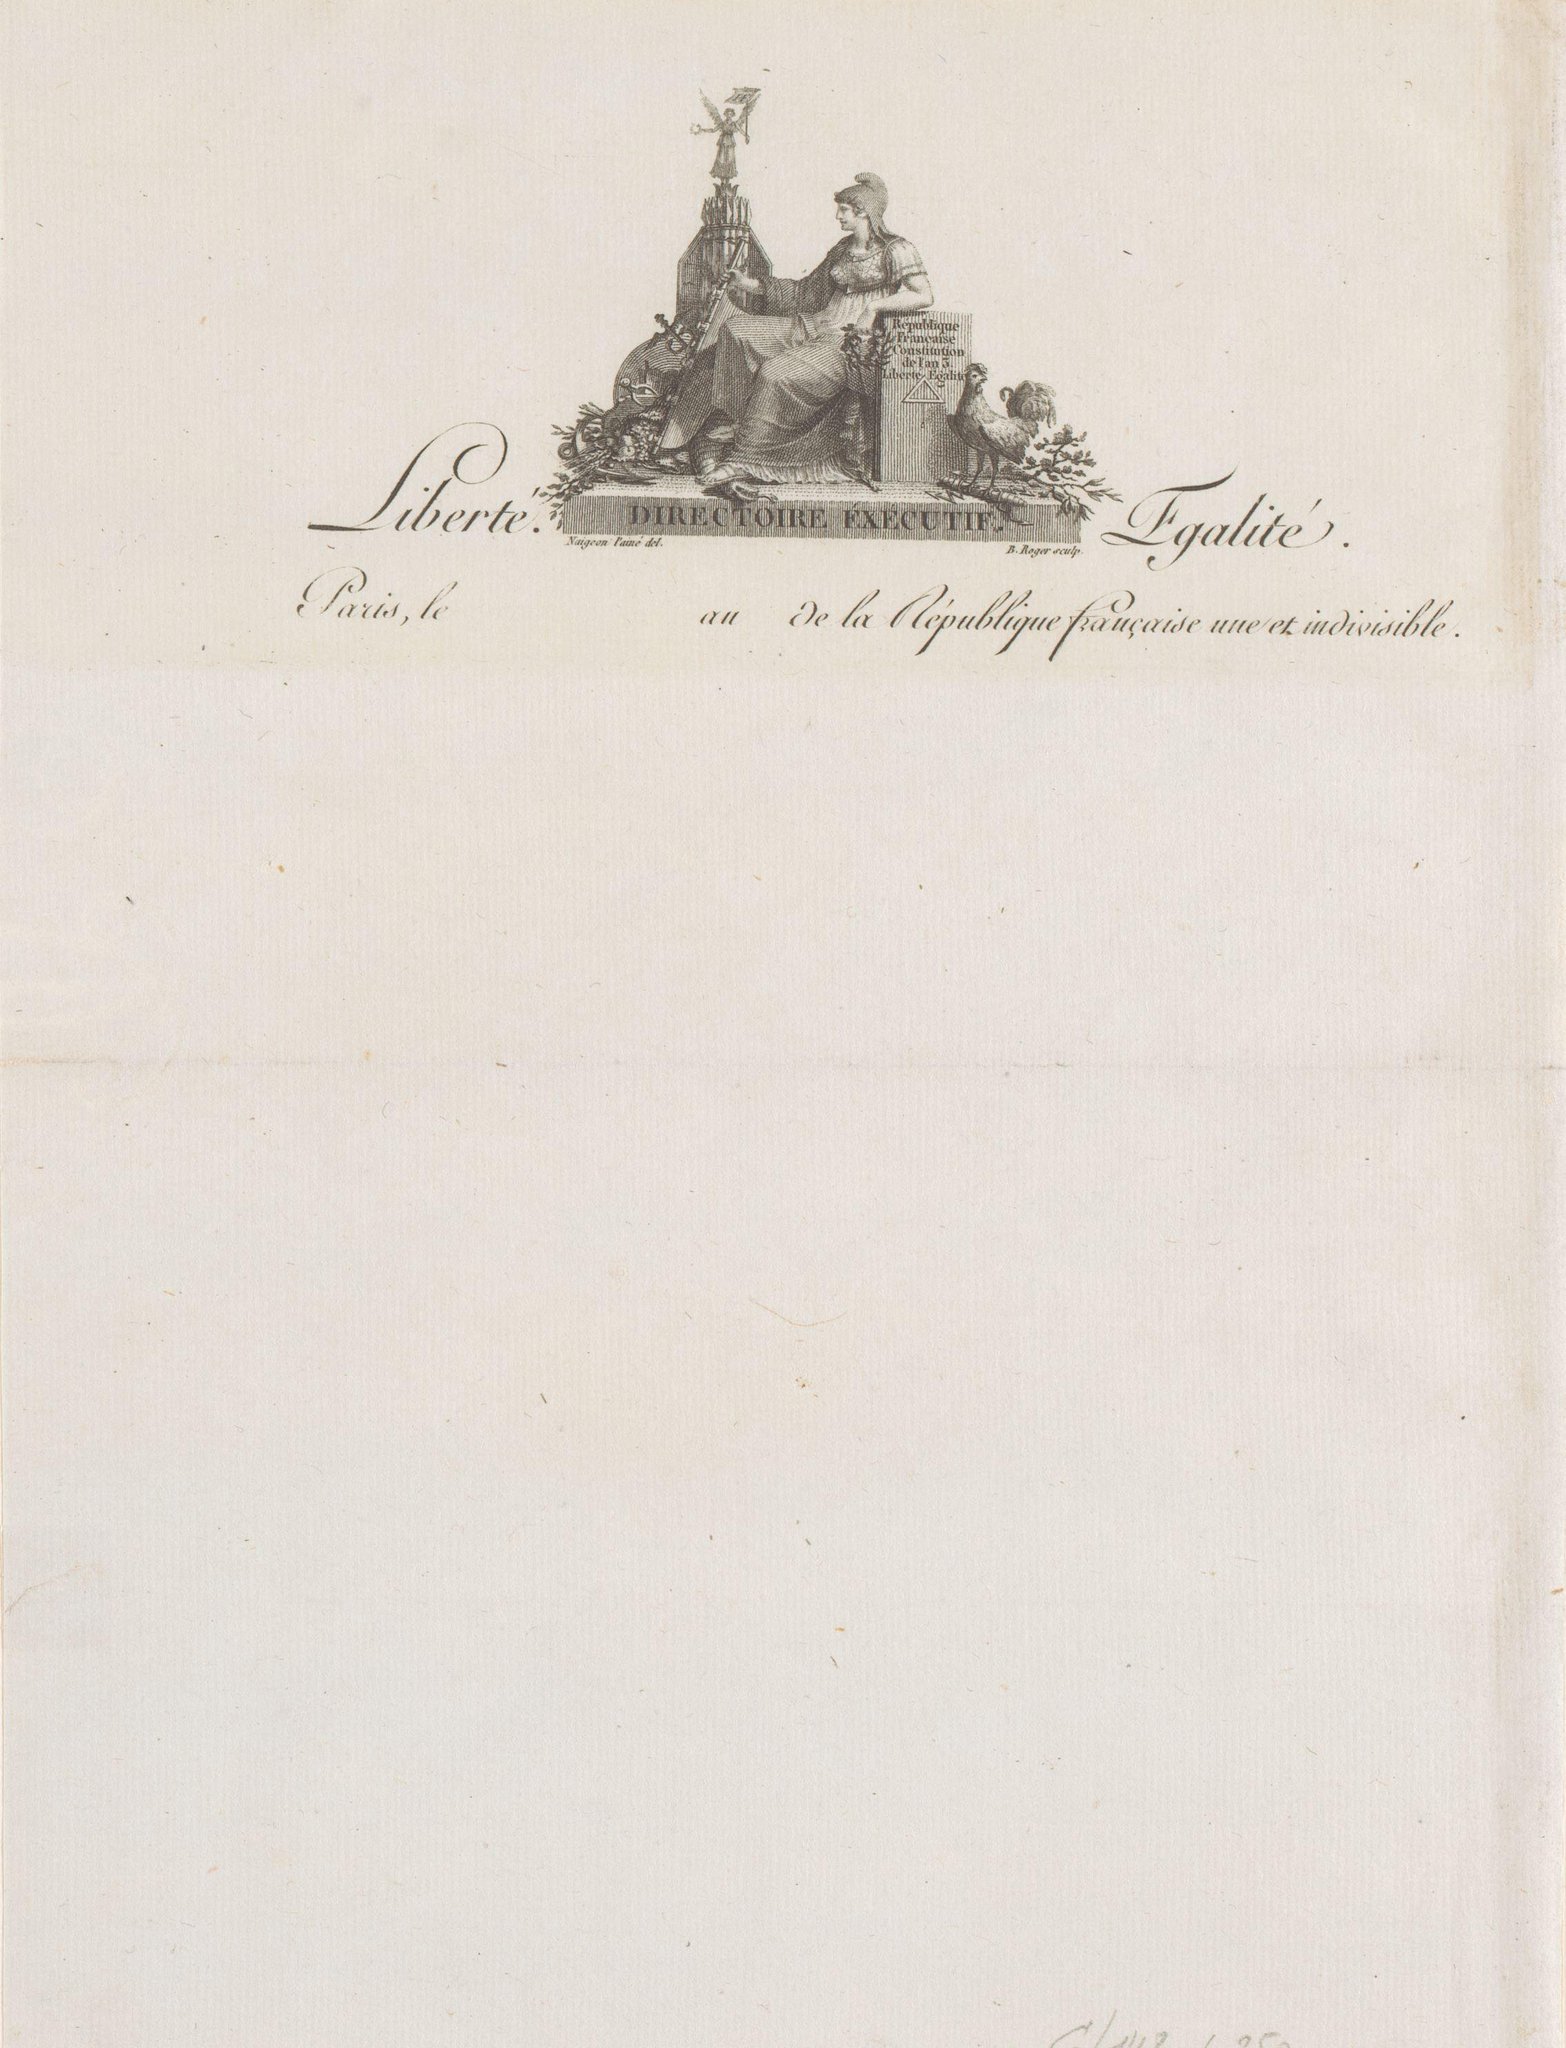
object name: print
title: République Française/ Constitution/ de l'An 3./ Liberté Égalité./ Directoire Éxécutif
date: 1804-1841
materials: paper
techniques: engraving, etching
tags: governmental and representative bodies, personifications of countries, nations, states, districts, etc., warfare; military affairs, letter, envelope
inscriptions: collector's mark: Lugt 2228